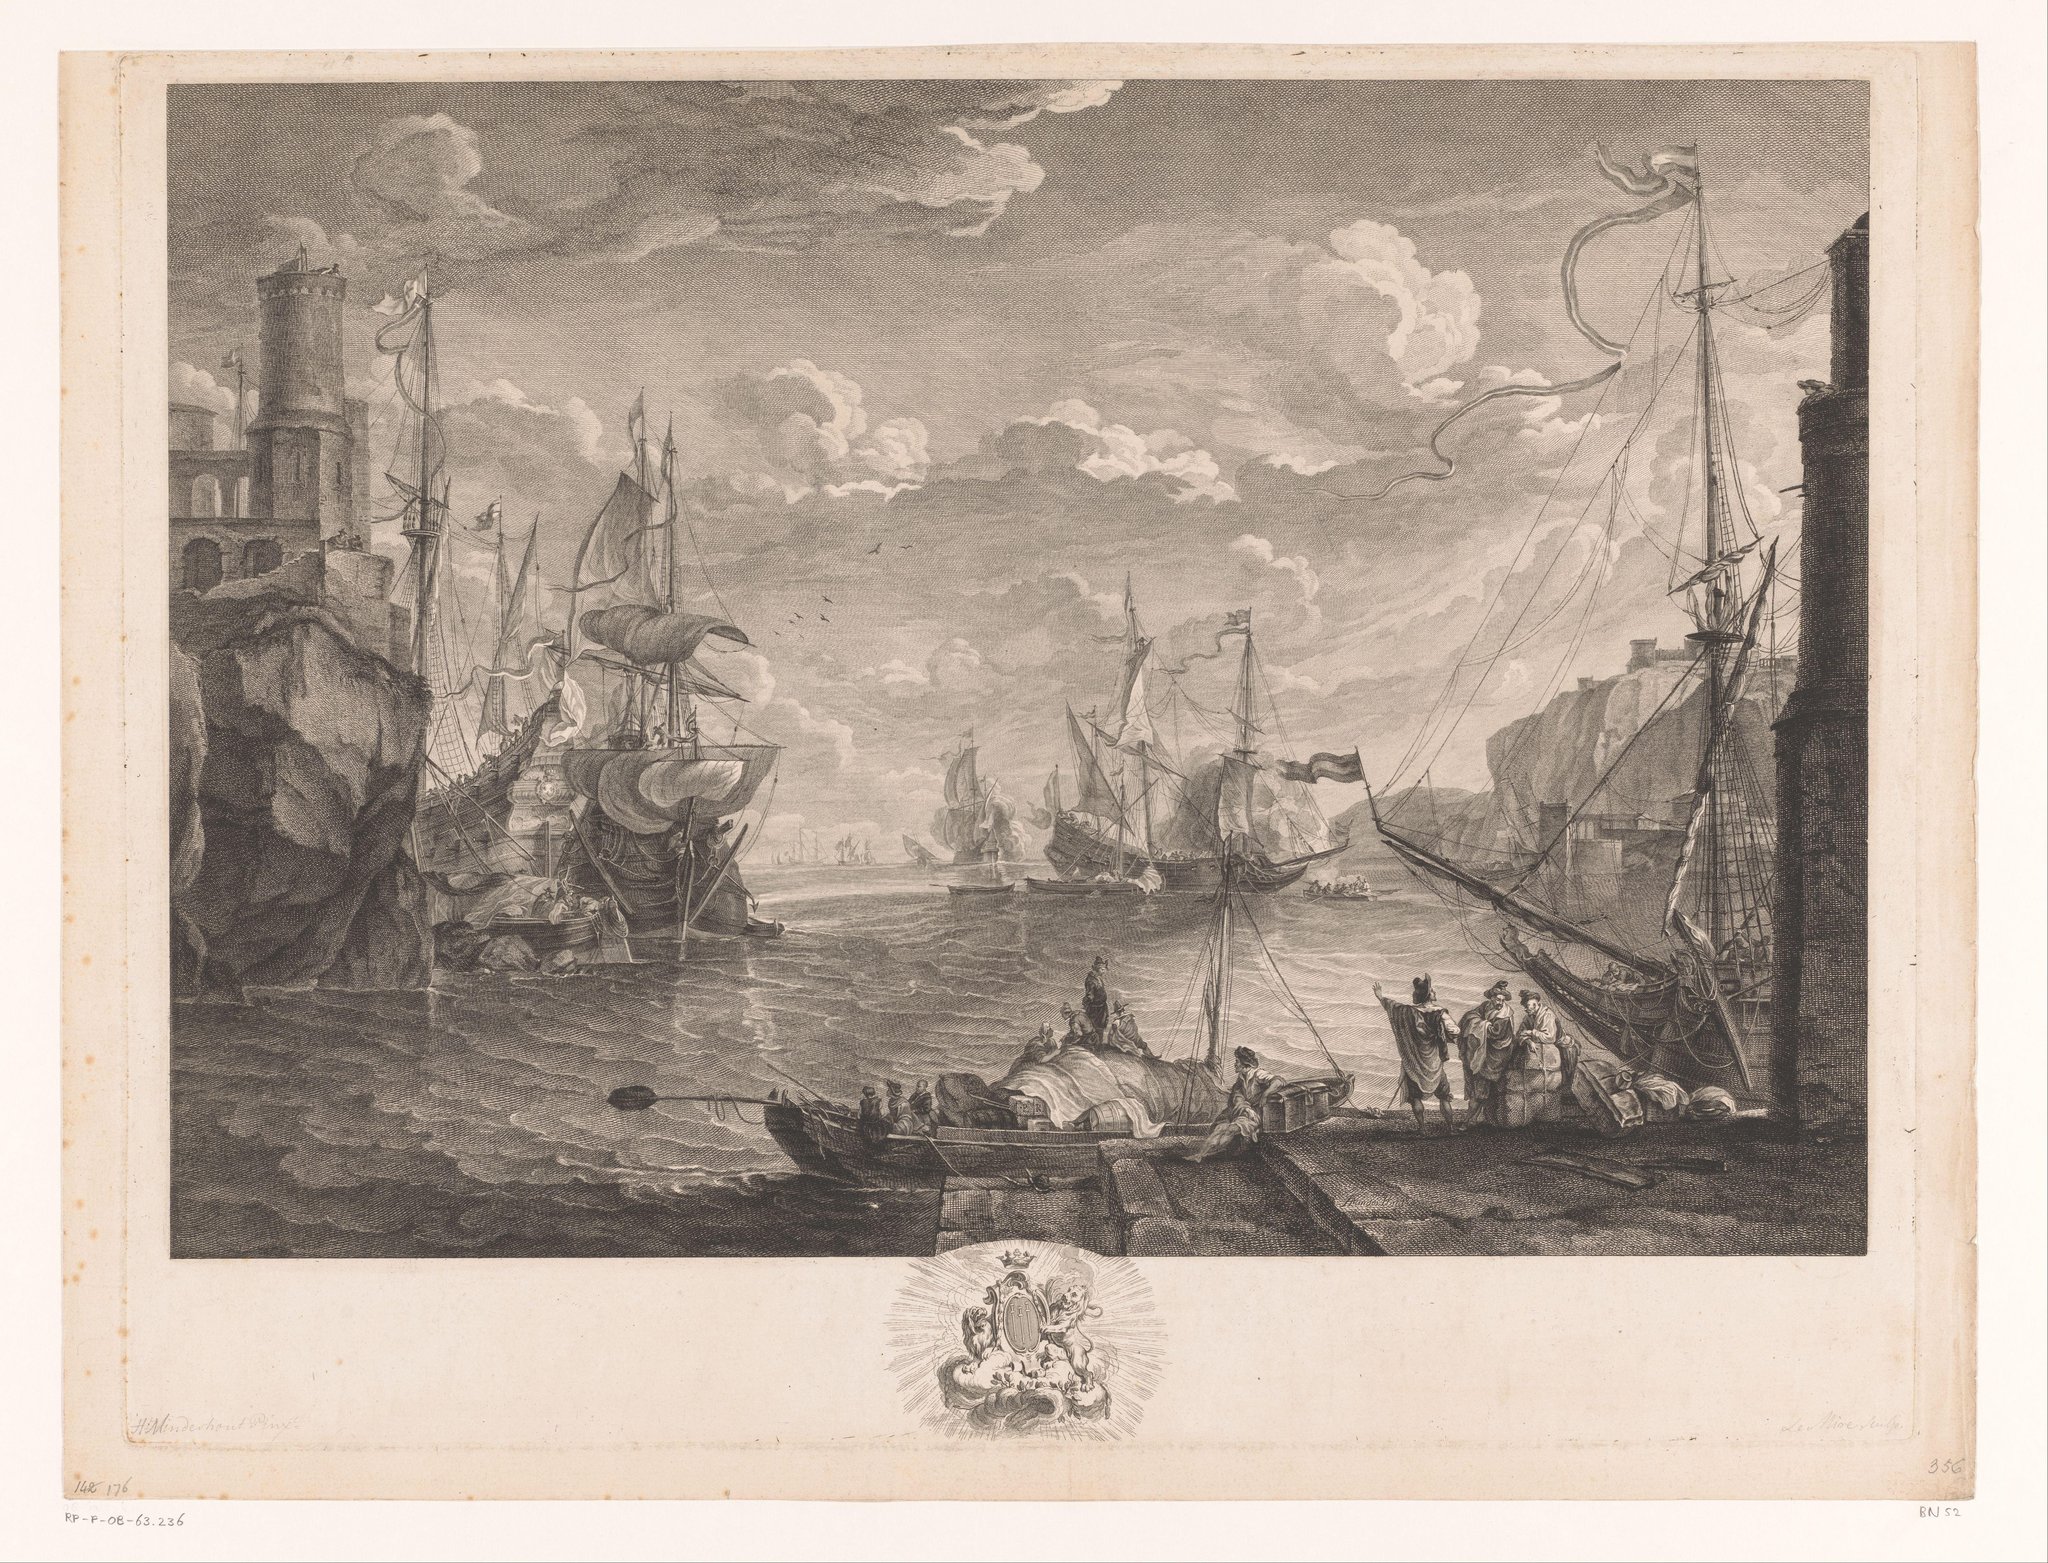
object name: print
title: Schepen in een haven aan een rotsachtige kust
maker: noël le mire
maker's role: print maker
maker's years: 1724-1801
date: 1759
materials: paper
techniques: engraving, etching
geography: france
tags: harbour, rocky coast, ships (in general)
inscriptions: collector's mark: Lugt 240